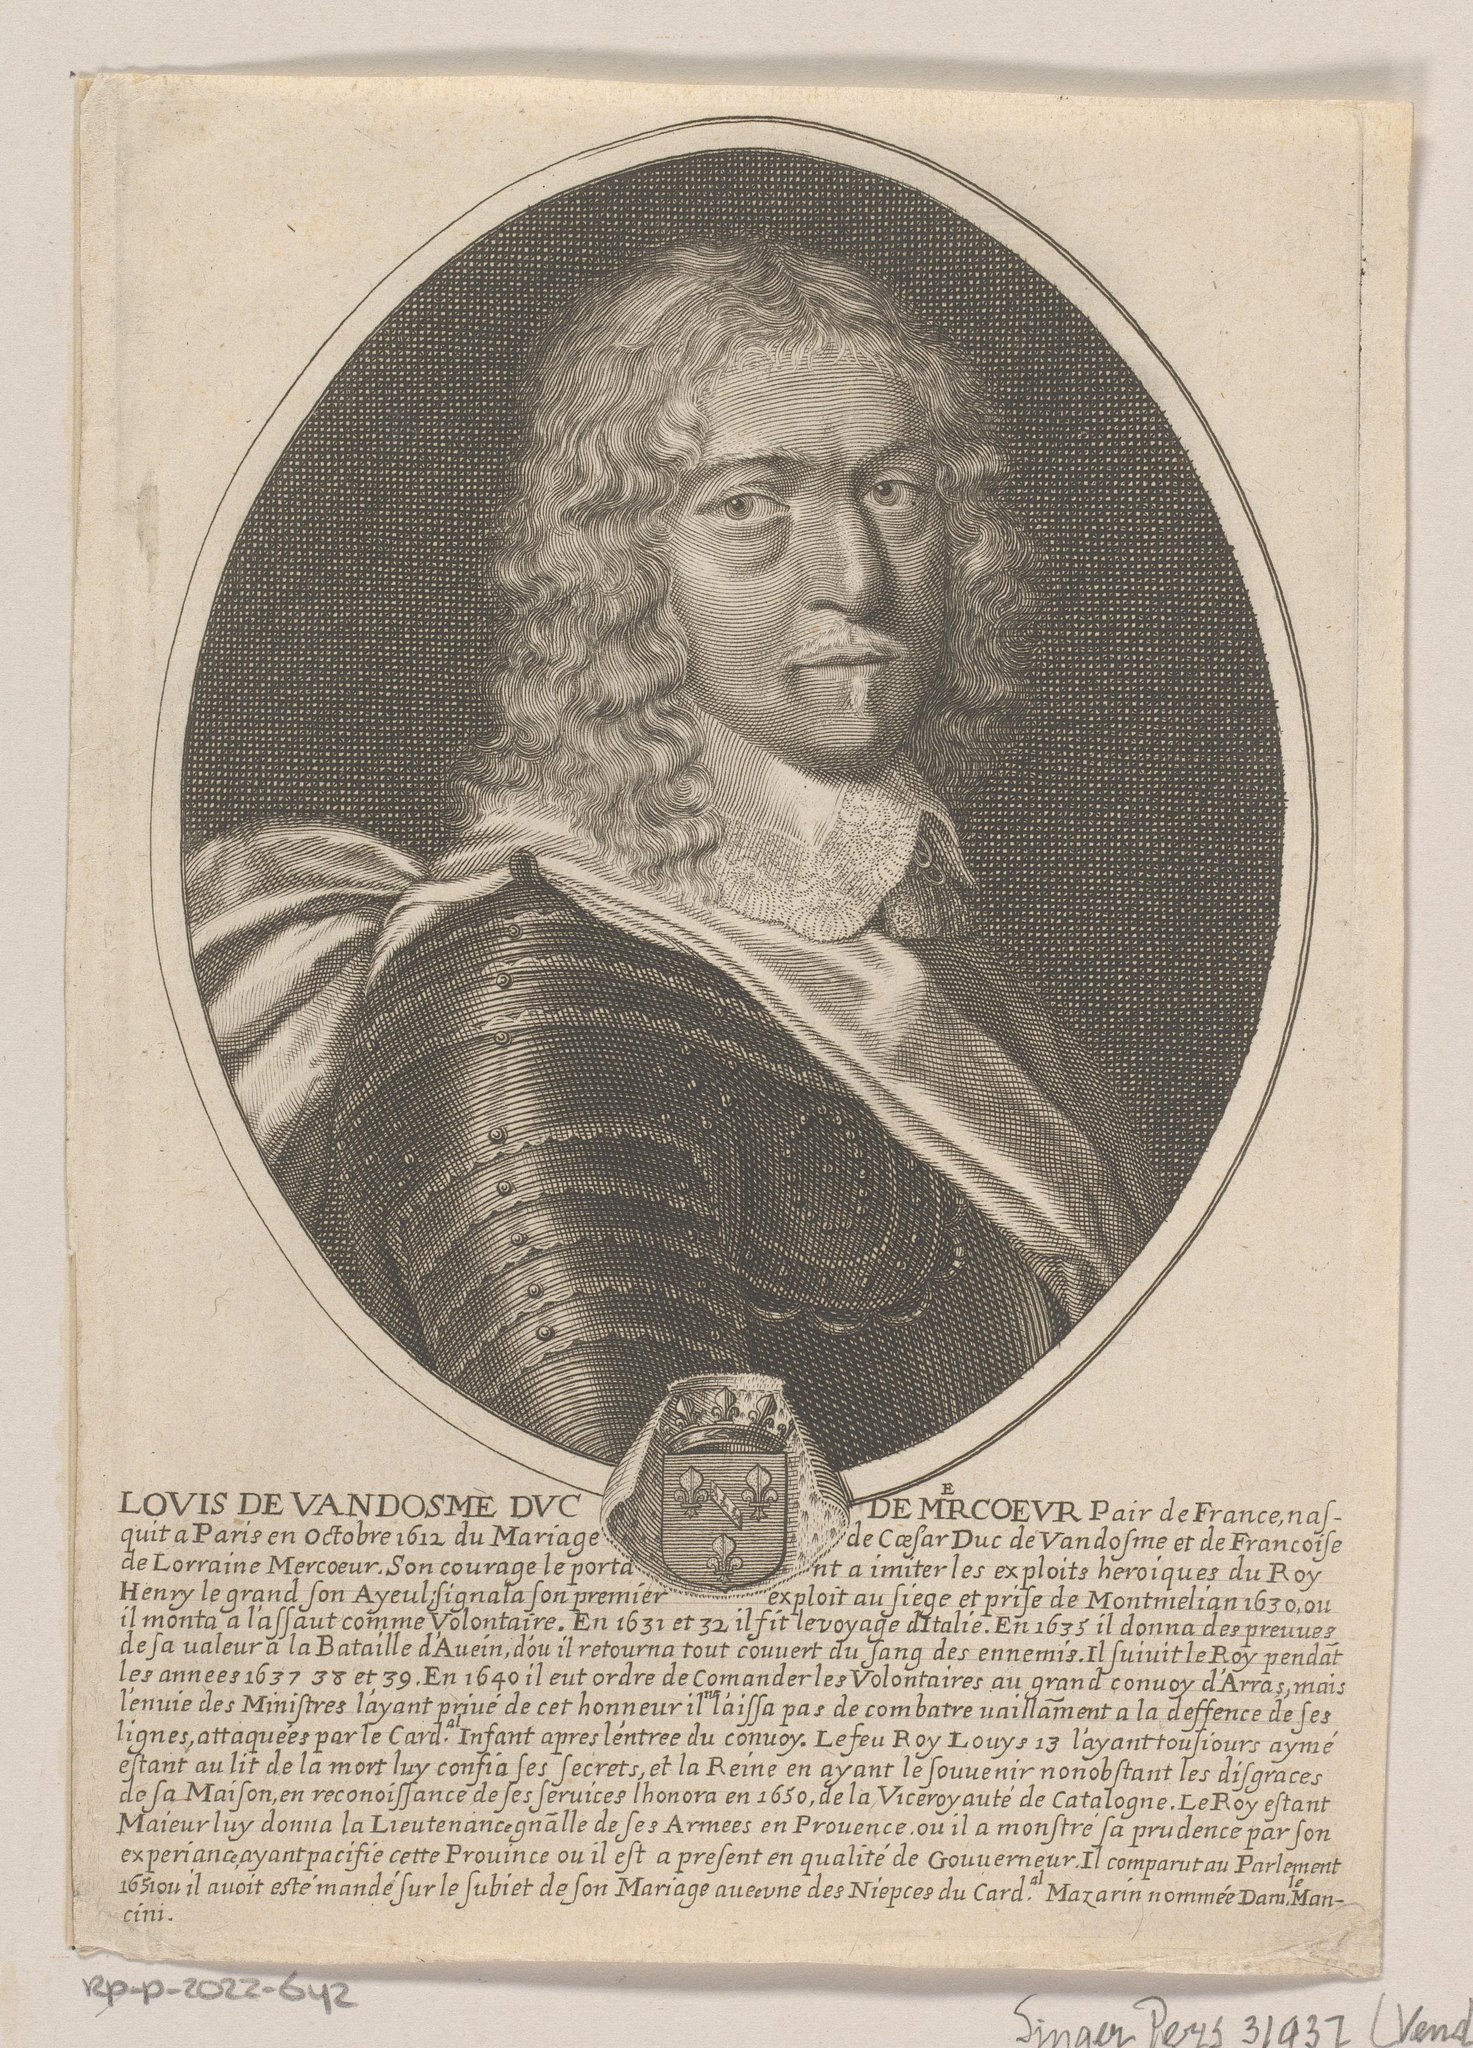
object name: print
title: Portret van Lodewijk II van Vendôme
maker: Anonymous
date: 1665-1800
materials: paper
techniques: engraving, etching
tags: paris, historical persons